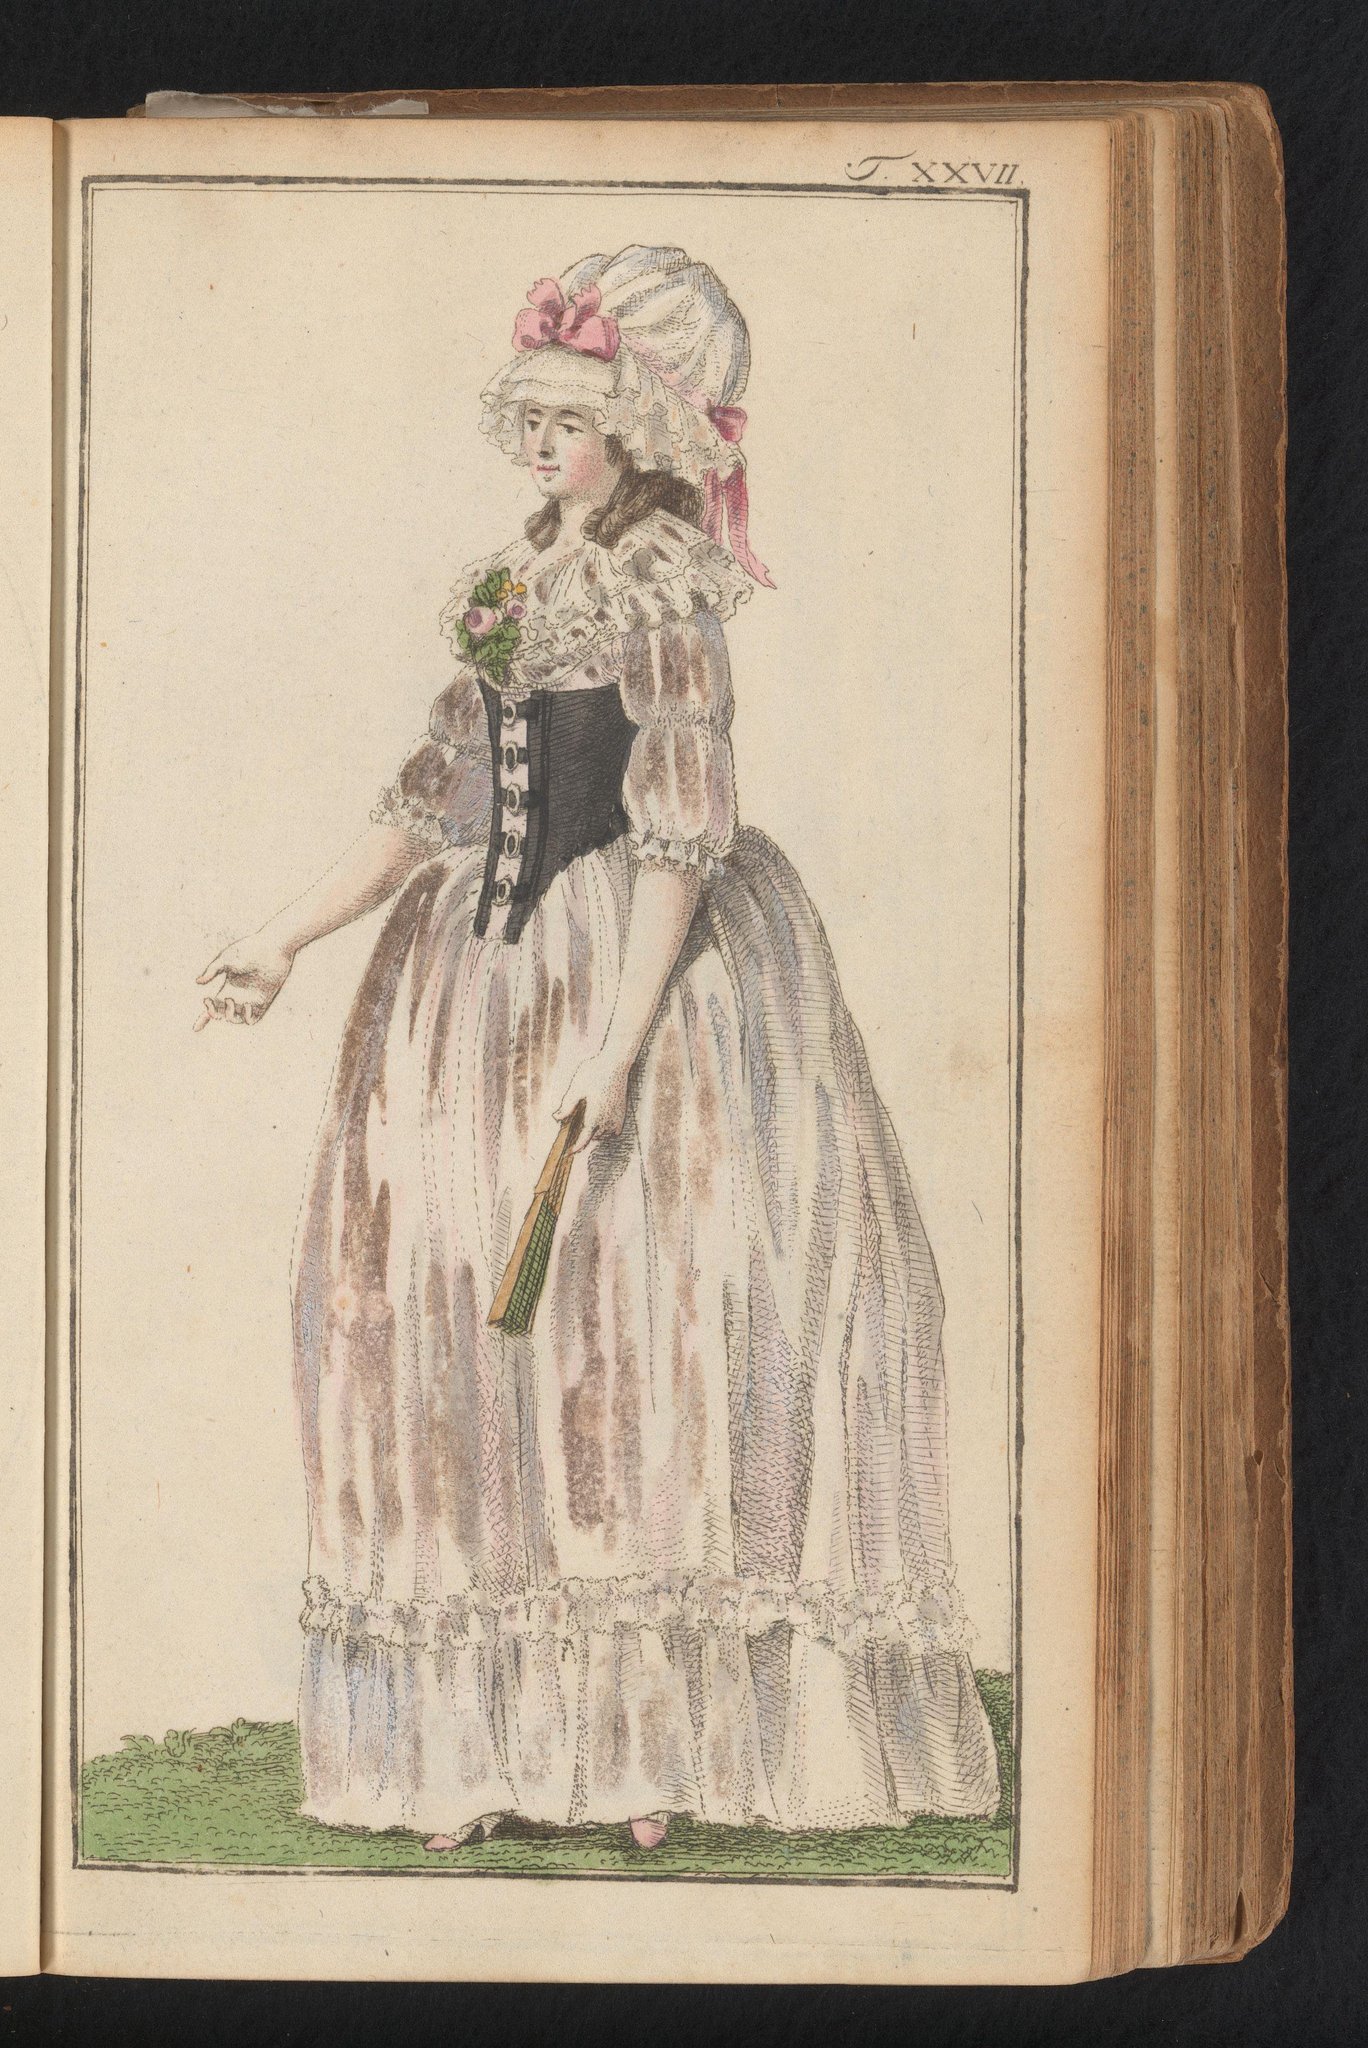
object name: fashion print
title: Journal des Luxus und der Moden 1786, Band I, T. 27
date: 1786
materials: paper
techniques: etching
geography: weimar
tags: fashion plates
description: Vrouw naar links, in een Engelse japon met wijde mouwen van mousseline. Over het lijfje wordt volgens de nieuwste mode een corselet met vijf stalen gespen gedragen. Het is een groot corselet naar Parijs voorbeeld van zwarte tafzijde. Fichu van kant met dubbele falbala. Hoed 'à la Horja' van Italiaanse kant op het hoofd. Dit type hoed is naar de Weense mode. (Horja was een boerse rebel) Waaier in de hand. Prent uit het modetijdschrift Journal des Luxus und der Moden, uitgegeven door Friedrich Justin Bertuch en Georg Melchior Kraus, Weimar, 1786-1826.